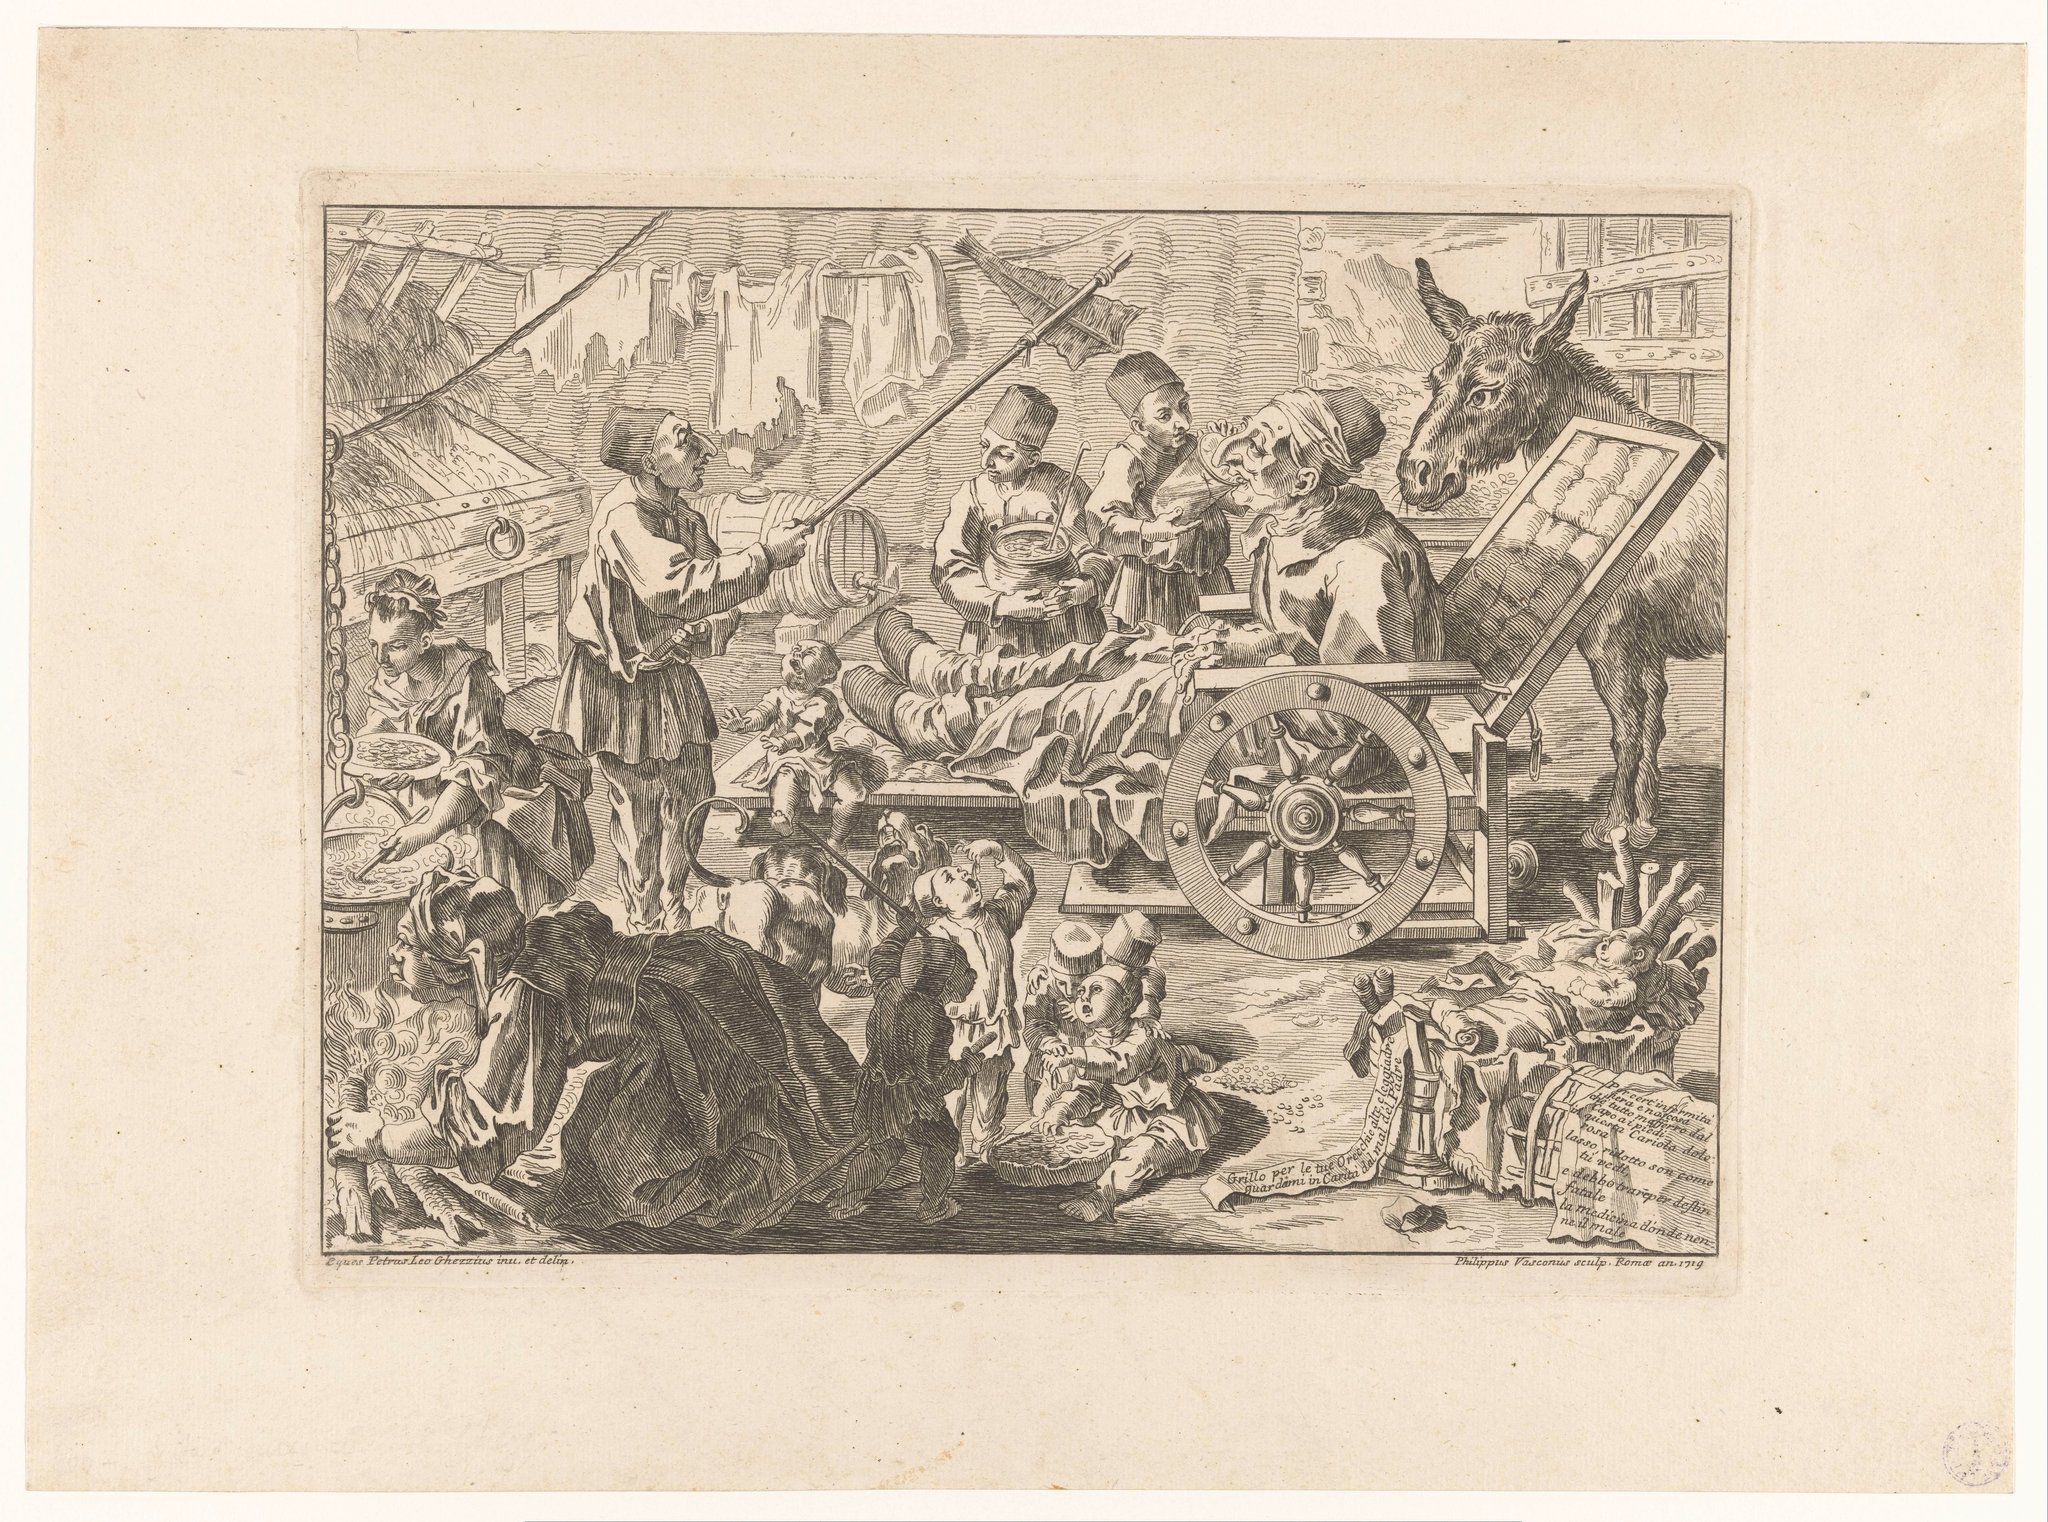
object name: print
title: Pulcinella in een verrijdbare stoel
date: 1719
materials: paper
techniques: etching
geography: italy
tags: wheelchair, bathchair, types in 'commedia dell'arte': pulcinella, kitchen-interior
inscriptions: collector's mark: Lugt 2228, collector's mark: ‘Collezione Contessa Anna [...] Pecci-Blunt Roma Sparita N ...’, collector's mark: ‘[...]’, collector's mark: Lugt 2760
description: Pulcinella zittend in een verrijdbare stoel, omringd door een ezel en drie figuren die hem voeren en koelte toewuiven. Op de voorgrond wordt links gekookt, zitten in het midden vijf kinderen te eten en ligt rechts een jong kind in een wieg.